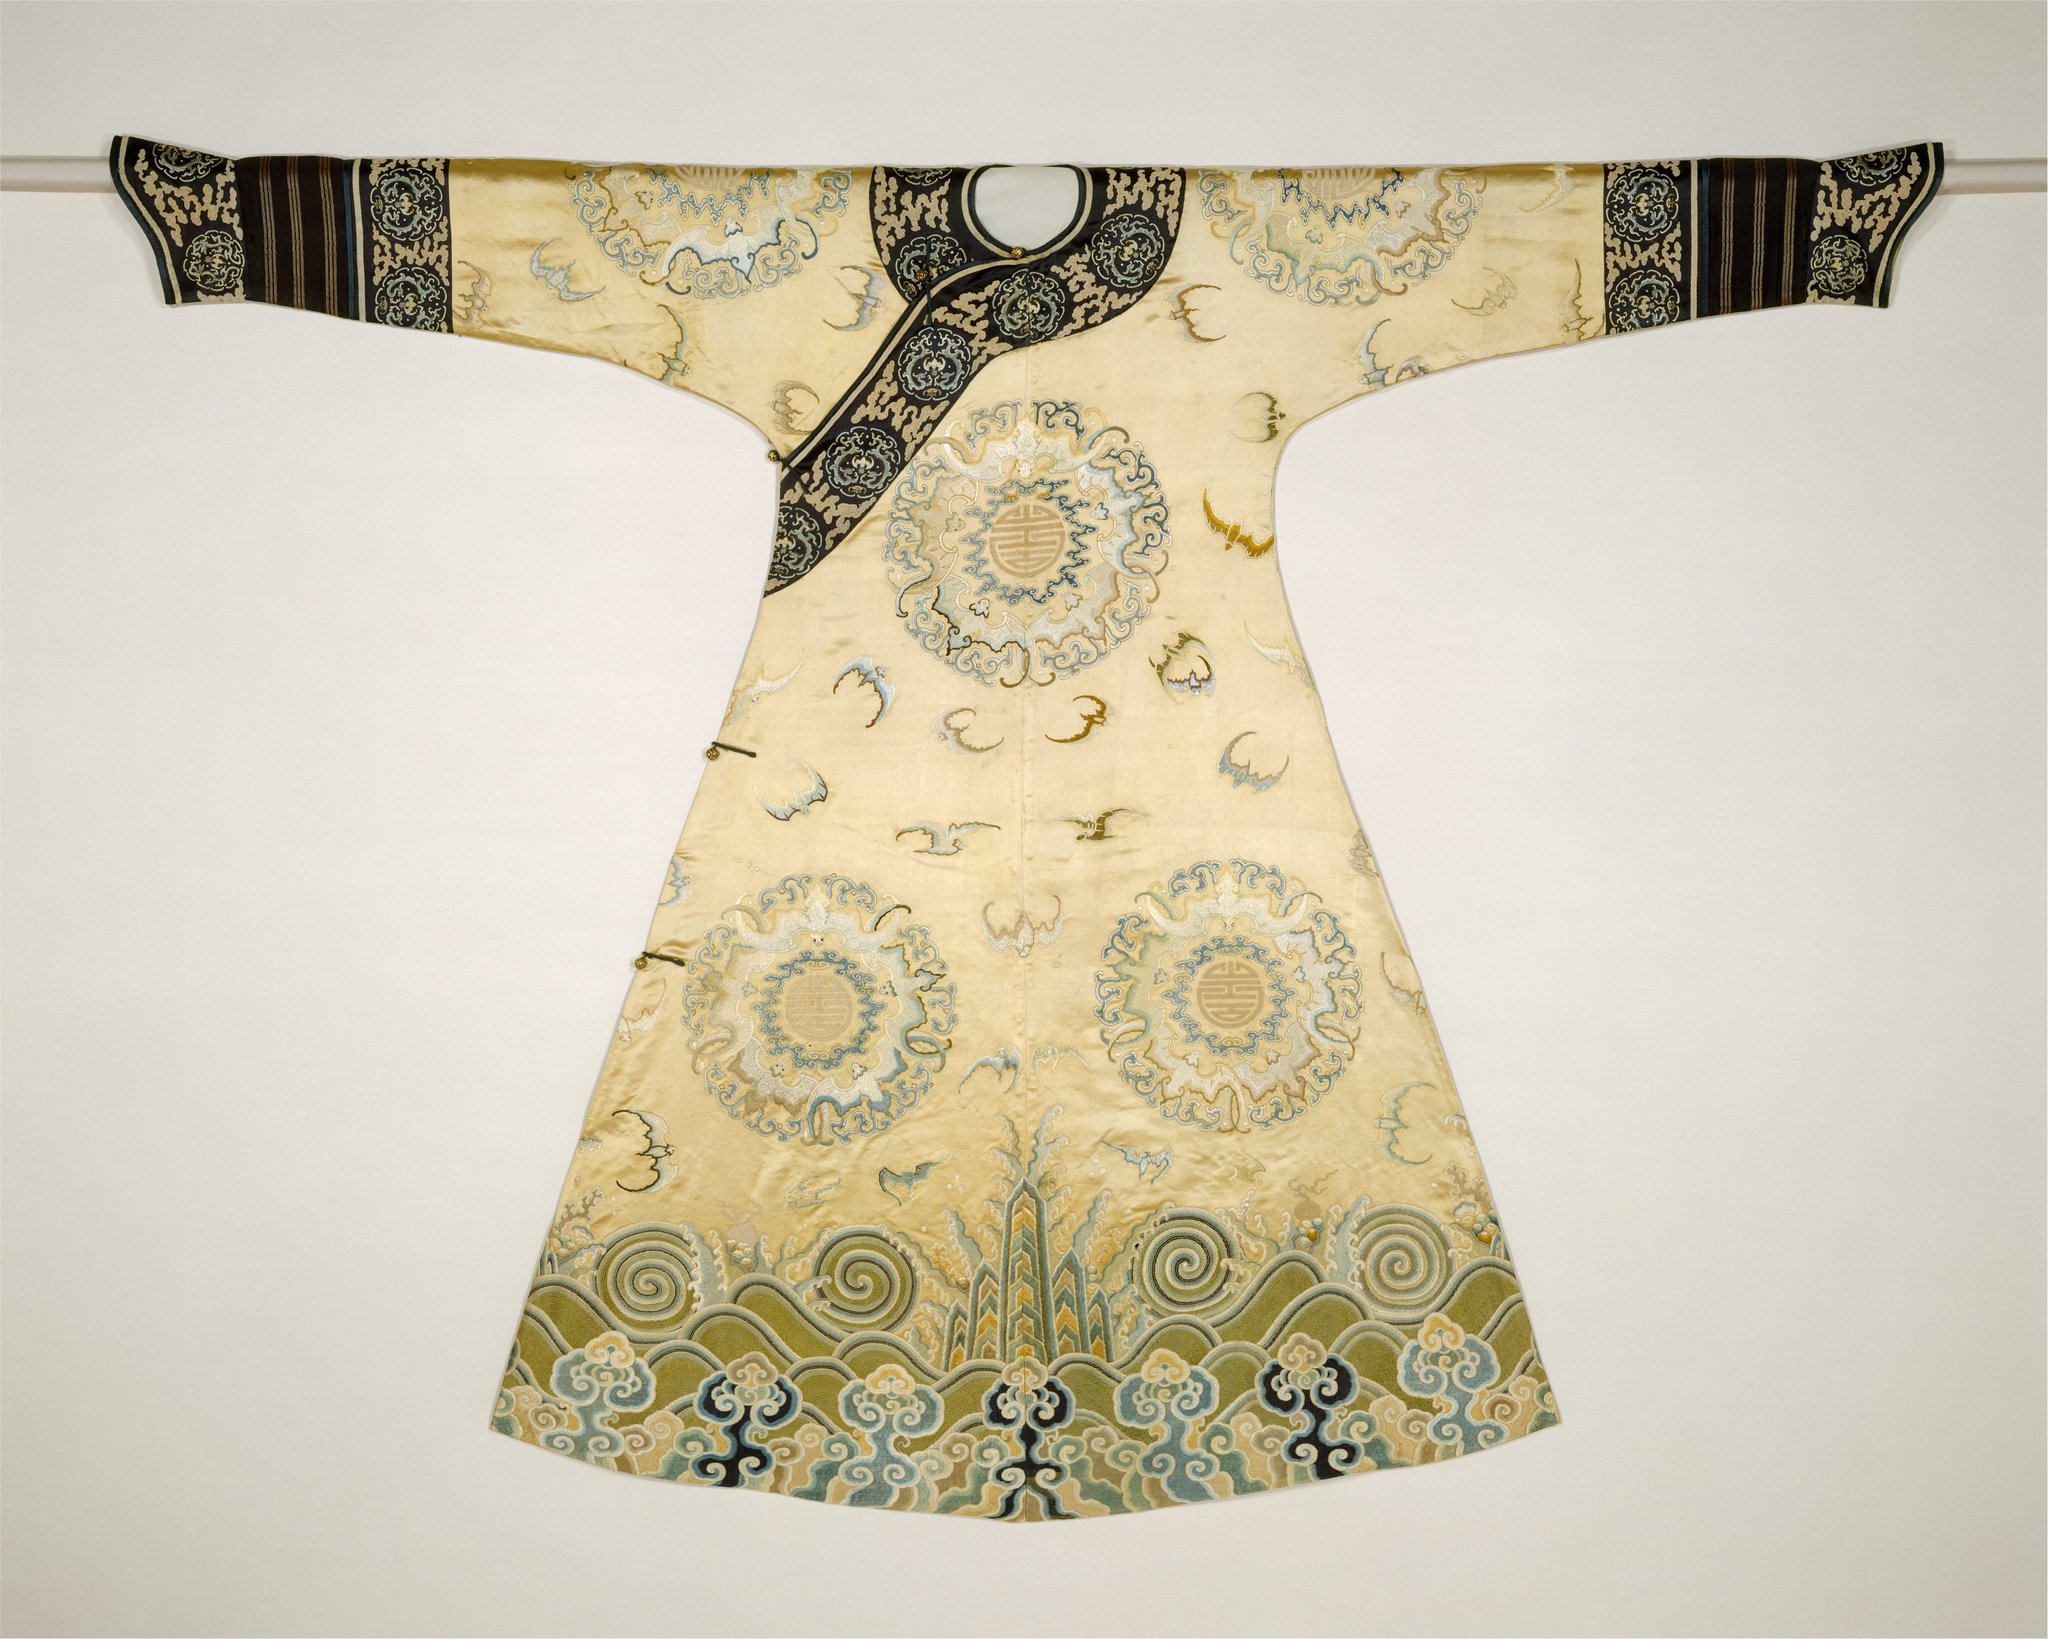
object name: robe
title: Woman’s ceremonial robe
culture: chinese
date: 1701-1750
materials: metal thread, silk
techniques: embroidery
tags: bats